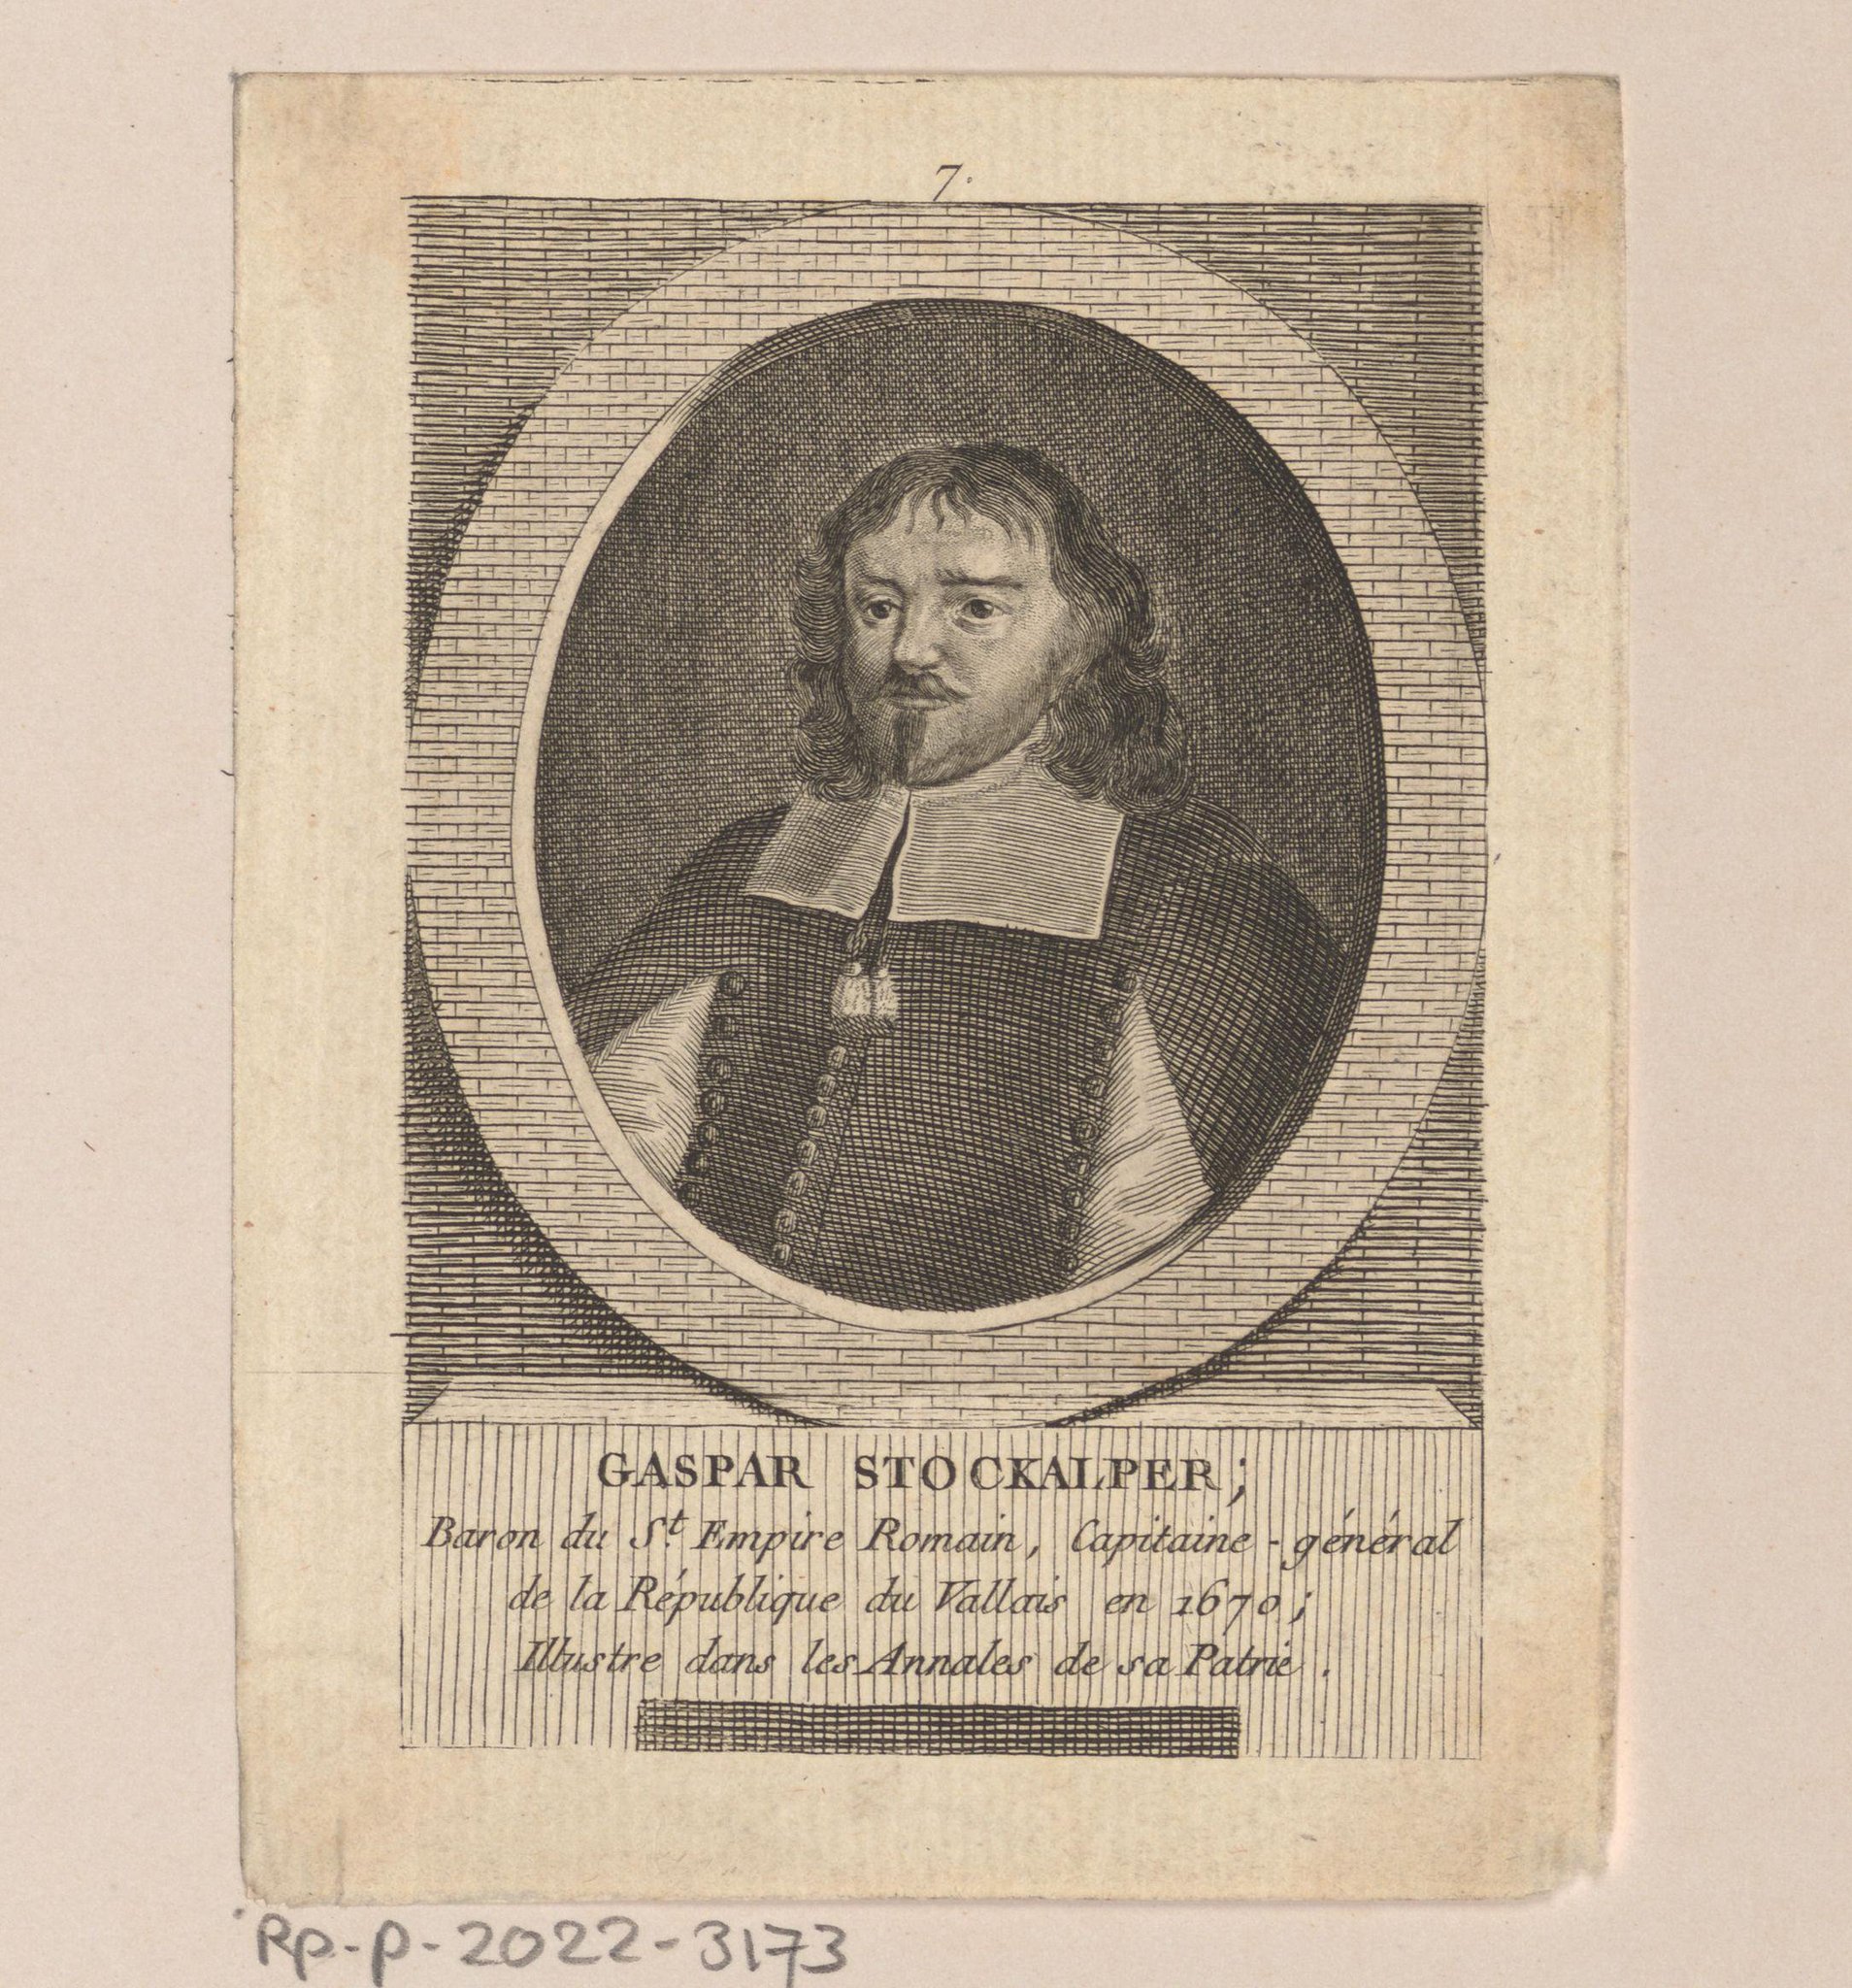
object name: print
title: Portret van Kaspar Stockalper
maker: Anonymous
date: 1770-1784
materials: paper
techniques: engraving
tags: banker, historical persons, merchant, salesman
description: Tweede staat van de prent gebruikt in: Tableaux de la Suisse (...). Parijs: Lamy, 1784, dl. 8.